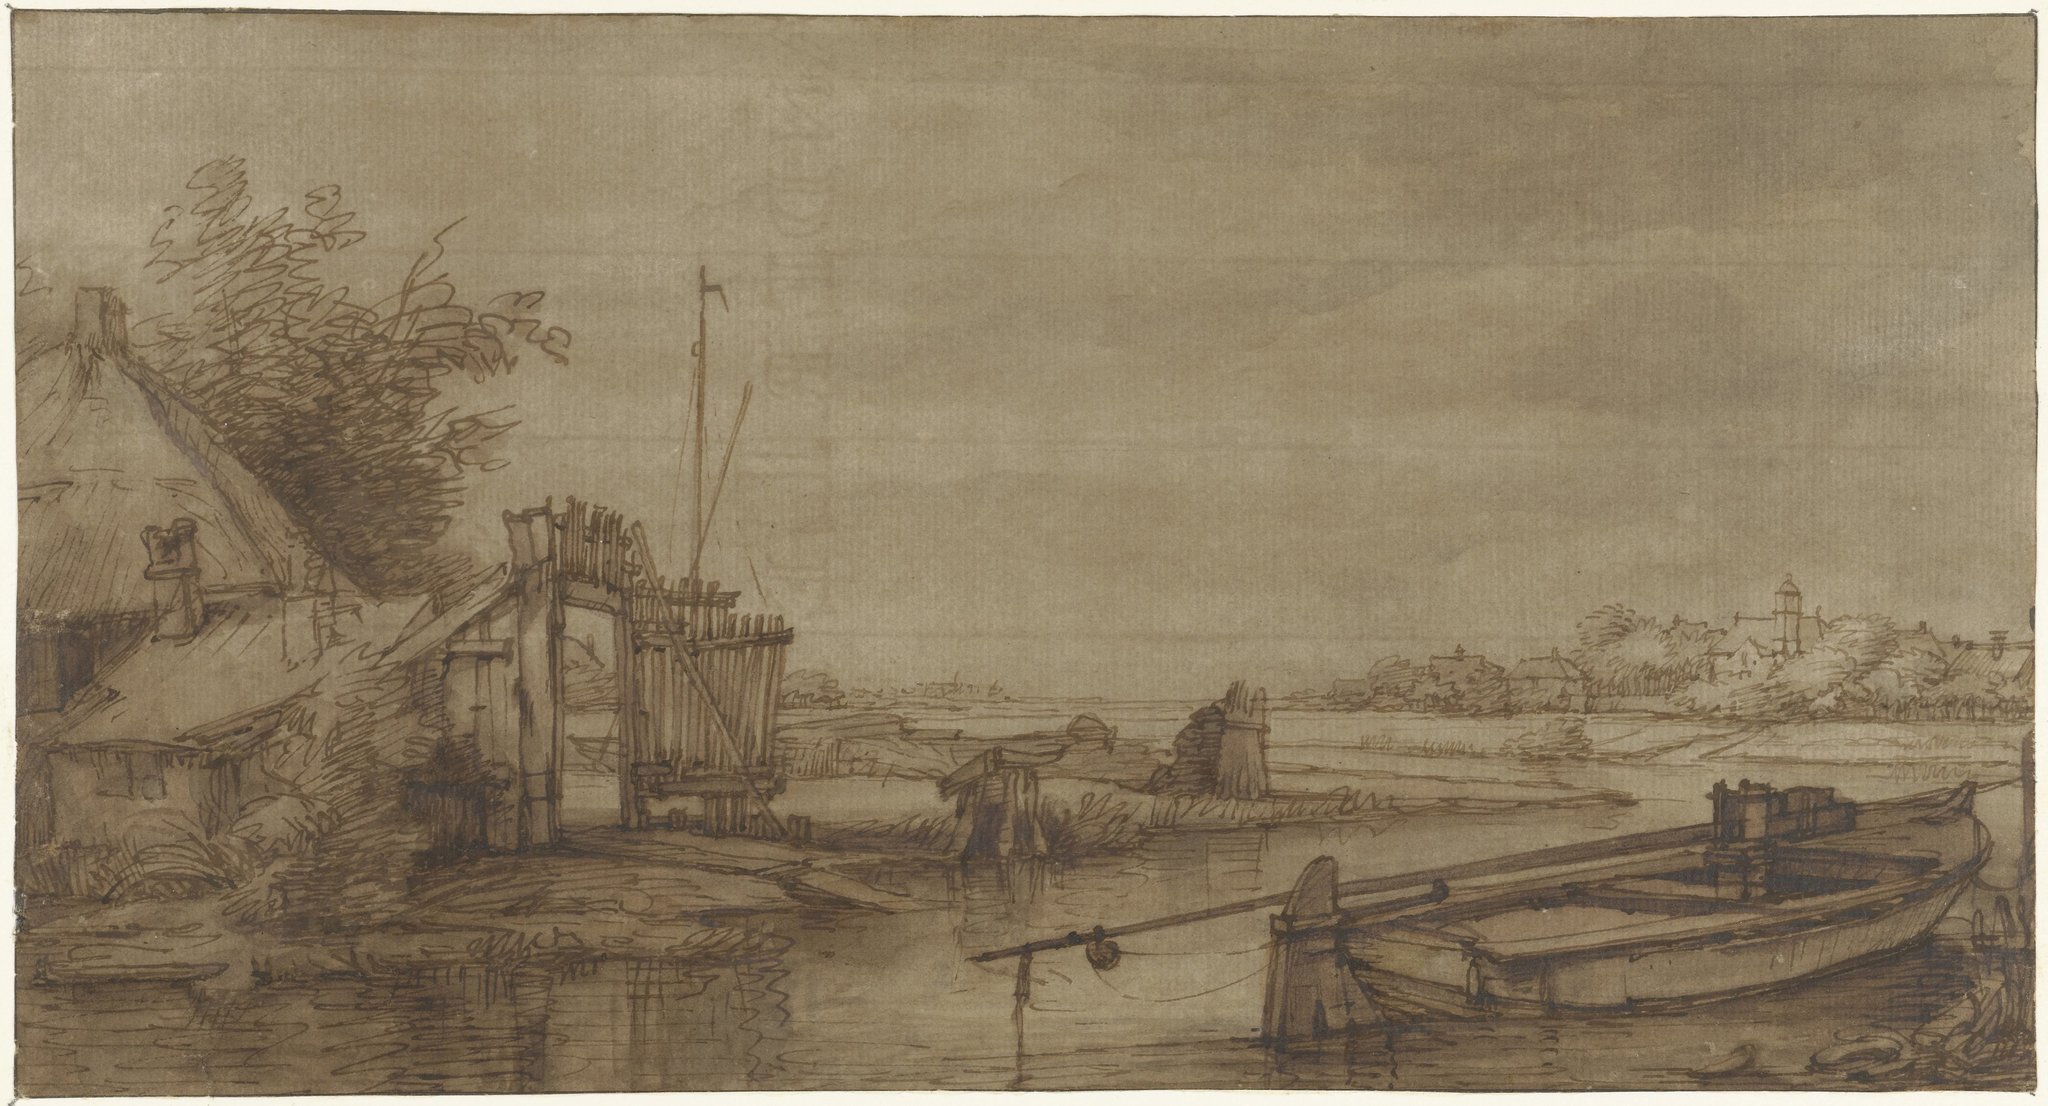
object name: drawing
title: Vaartgezicht met boerderij en liggende schuit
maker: jan hulswit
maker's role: draughtsman, painter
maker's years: 1766-1822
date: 1776-1822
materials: ink, paper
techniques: brush, pen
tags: farm or solitary house in landscape